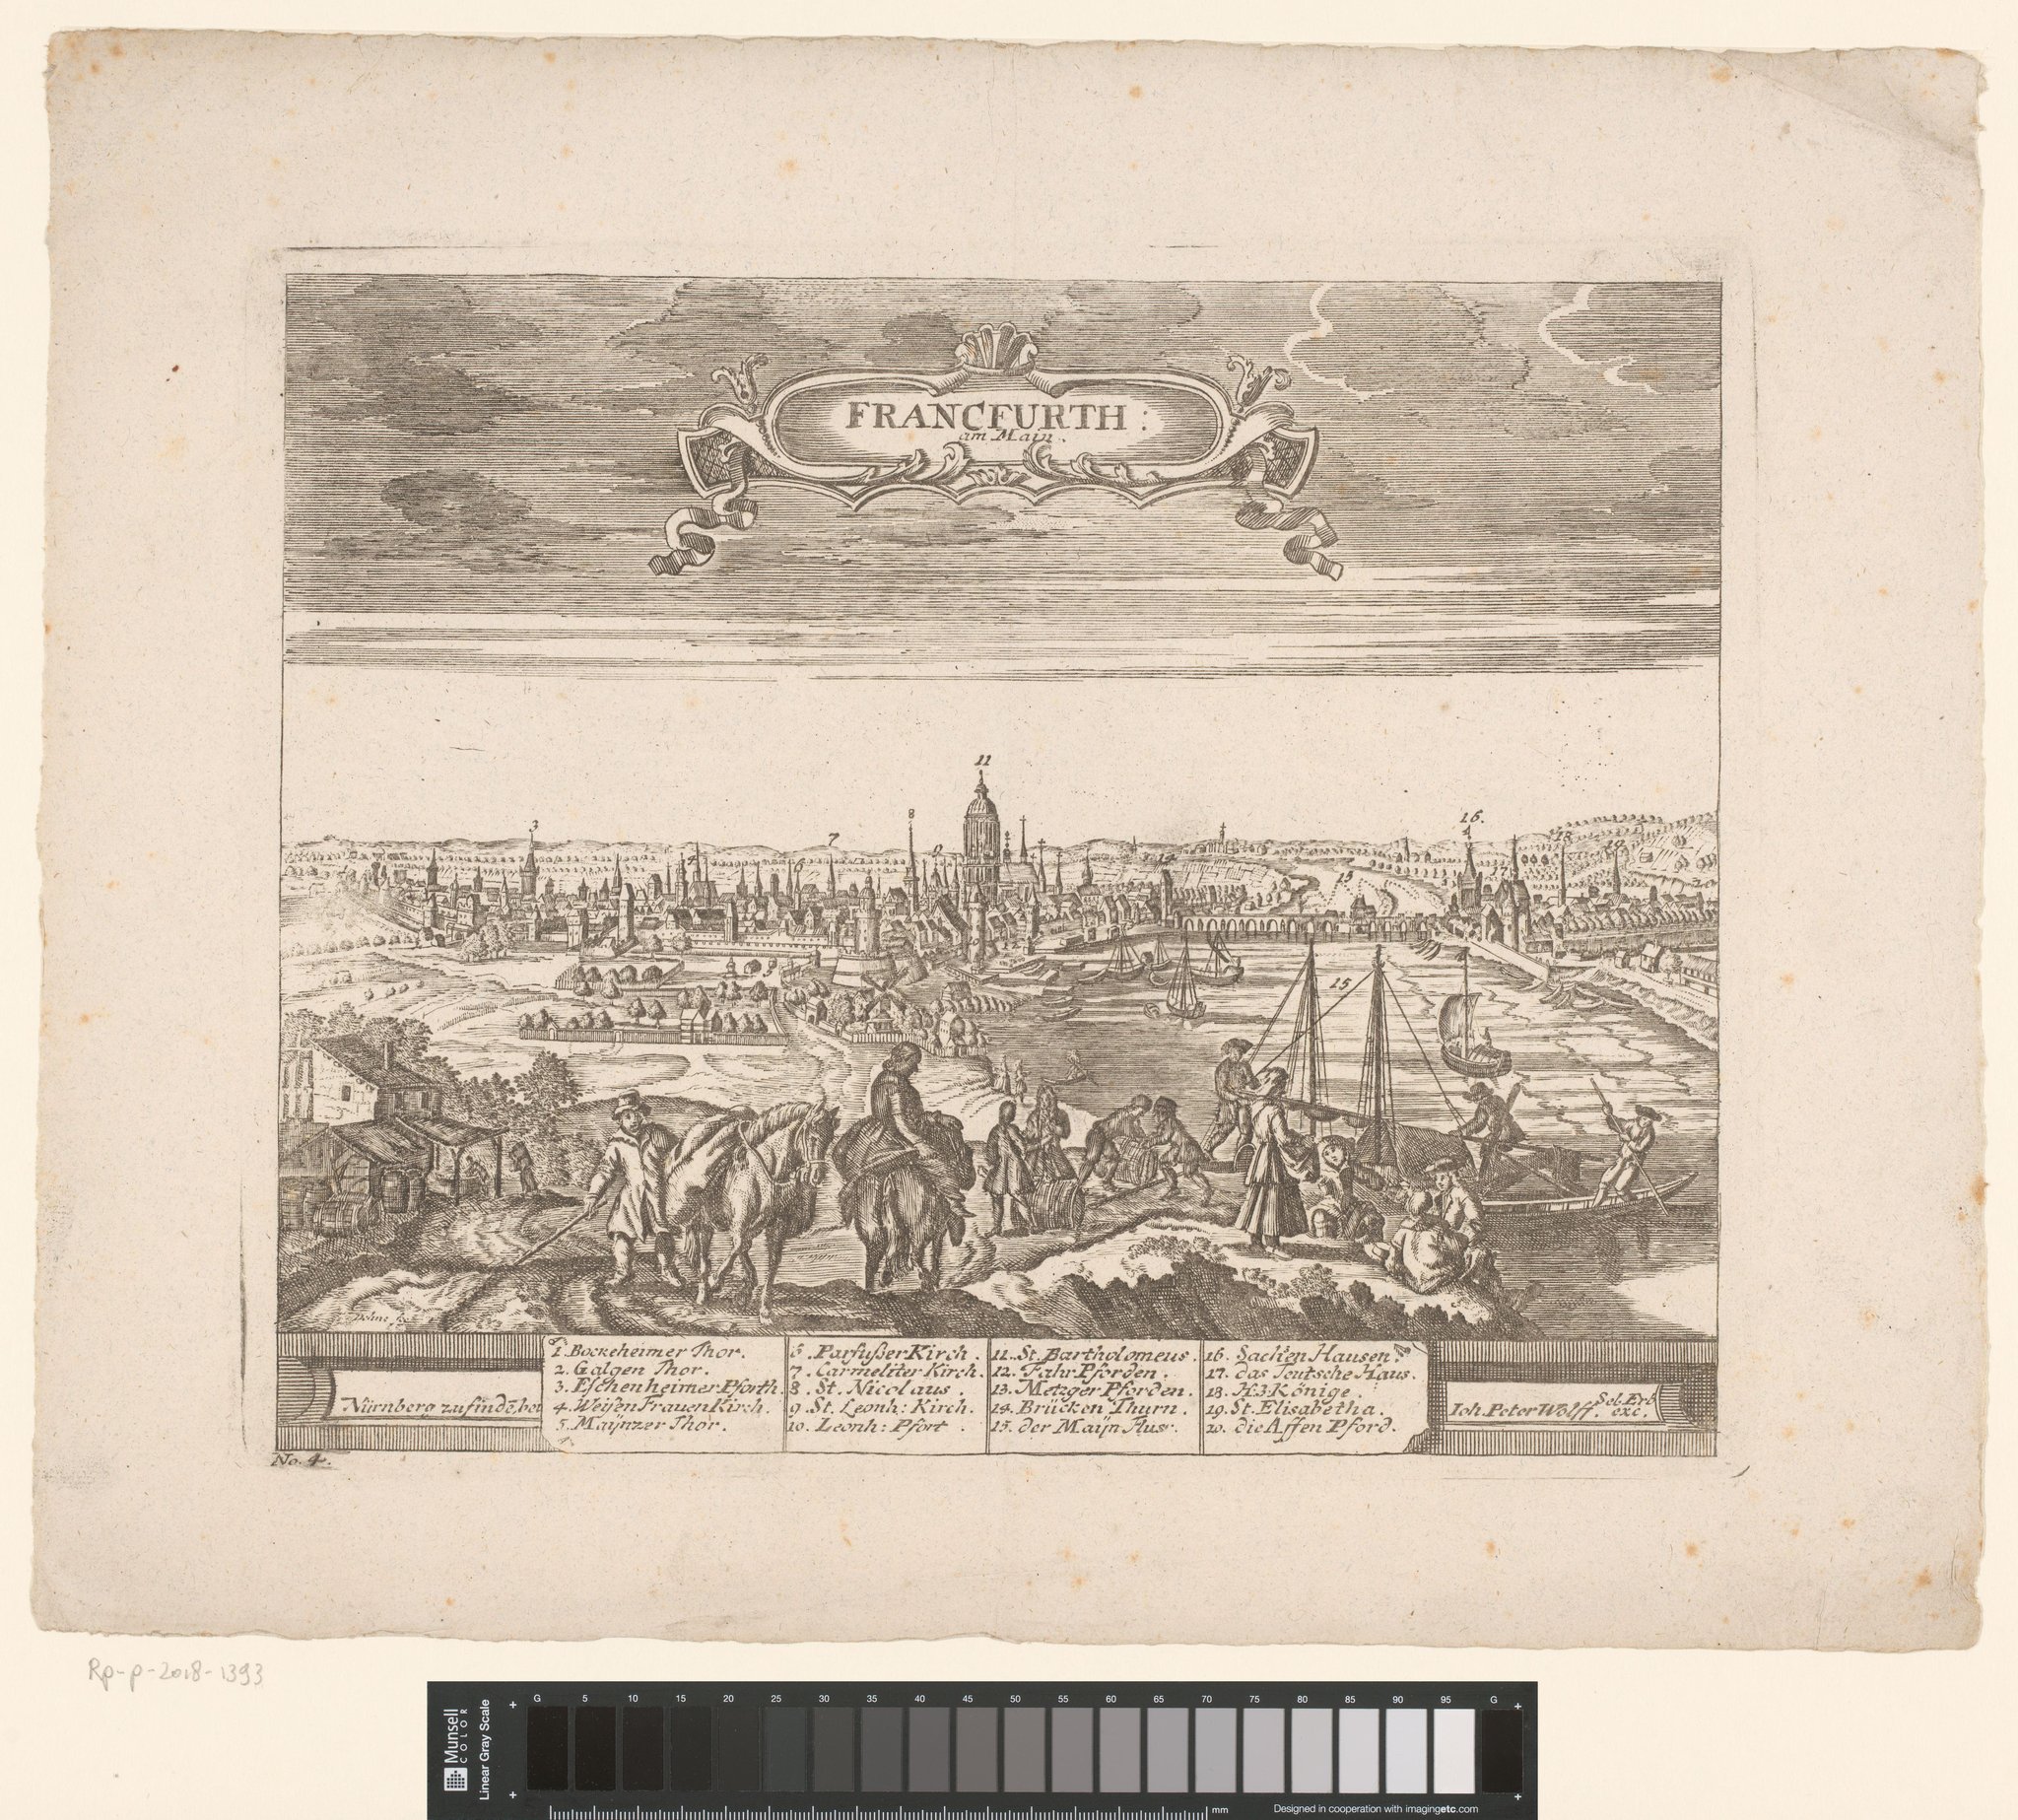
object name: print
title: Francfurth: am Main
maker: johann christoph dehne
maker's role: print maker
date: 1711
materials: paper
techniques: engraving, etching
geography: nuremberg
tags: prospect of city, town panorama, silhouette of city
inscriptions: collector's mark: Lugt 2228